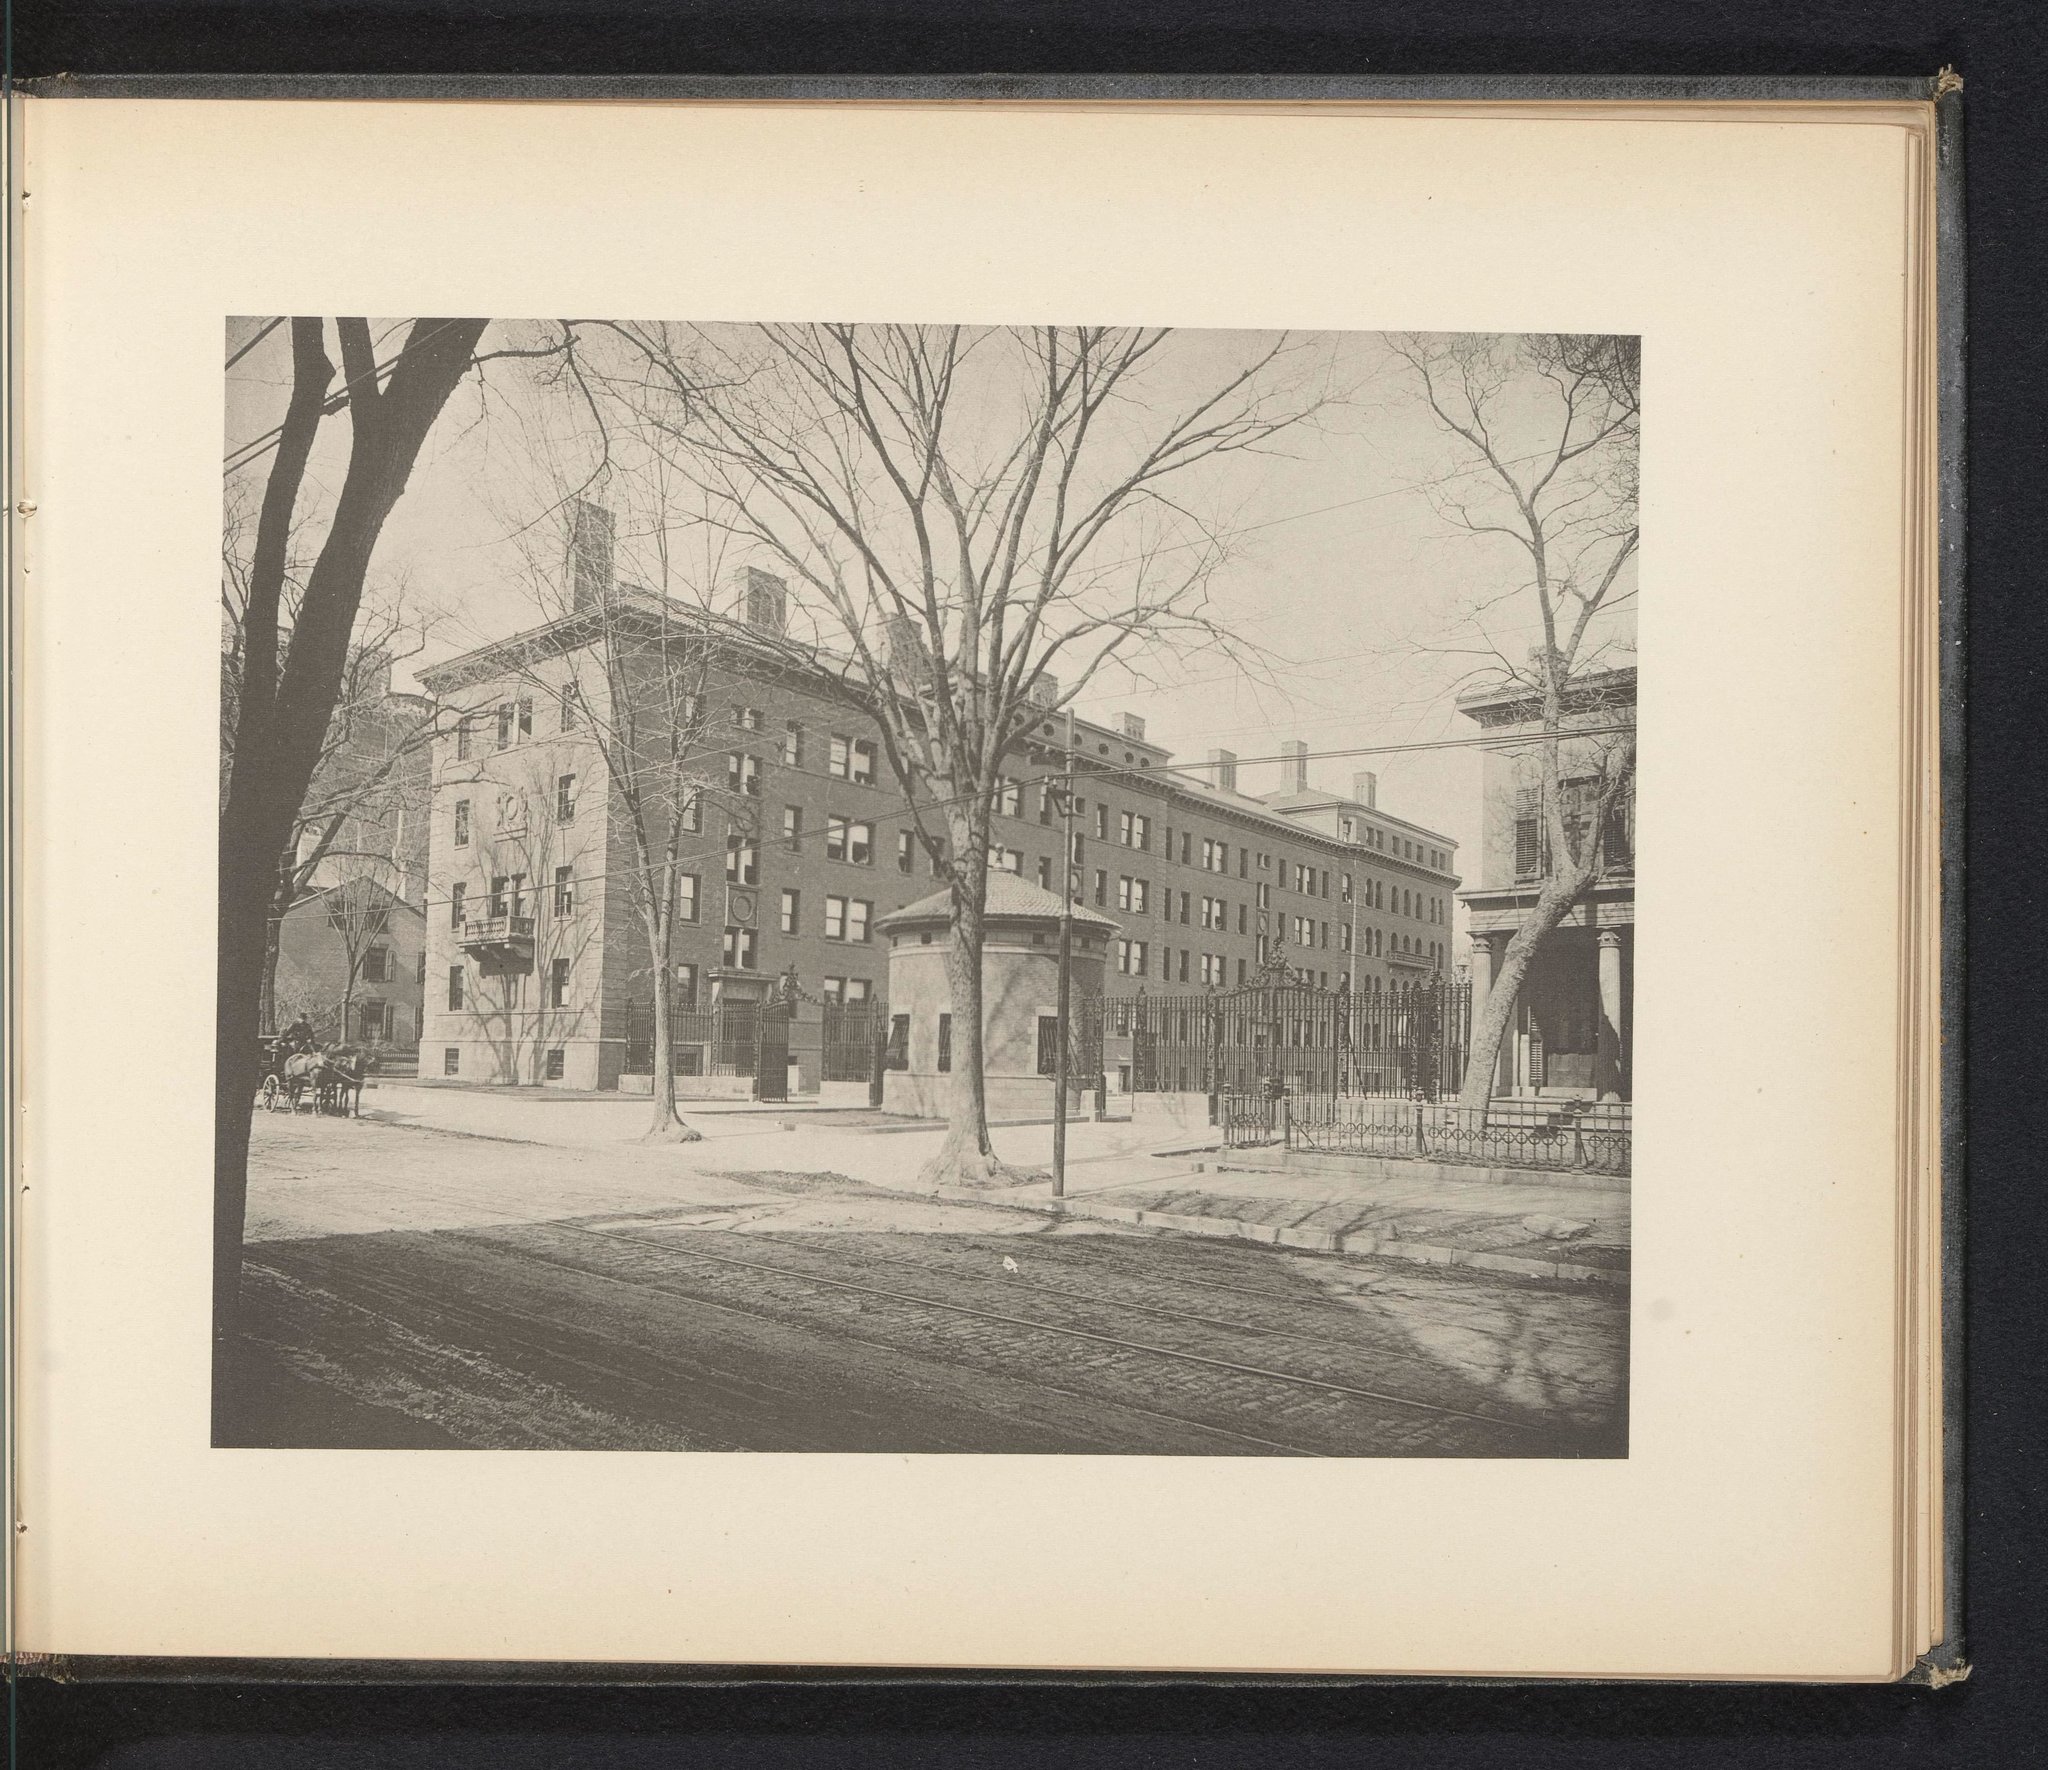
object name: photomechanical print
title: Exterieur van White Hall van Yale University te New Haven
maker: Anonymous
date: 1890-1895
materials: paper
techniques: photograph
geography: new haven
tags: university building, college, façade (of house or building)